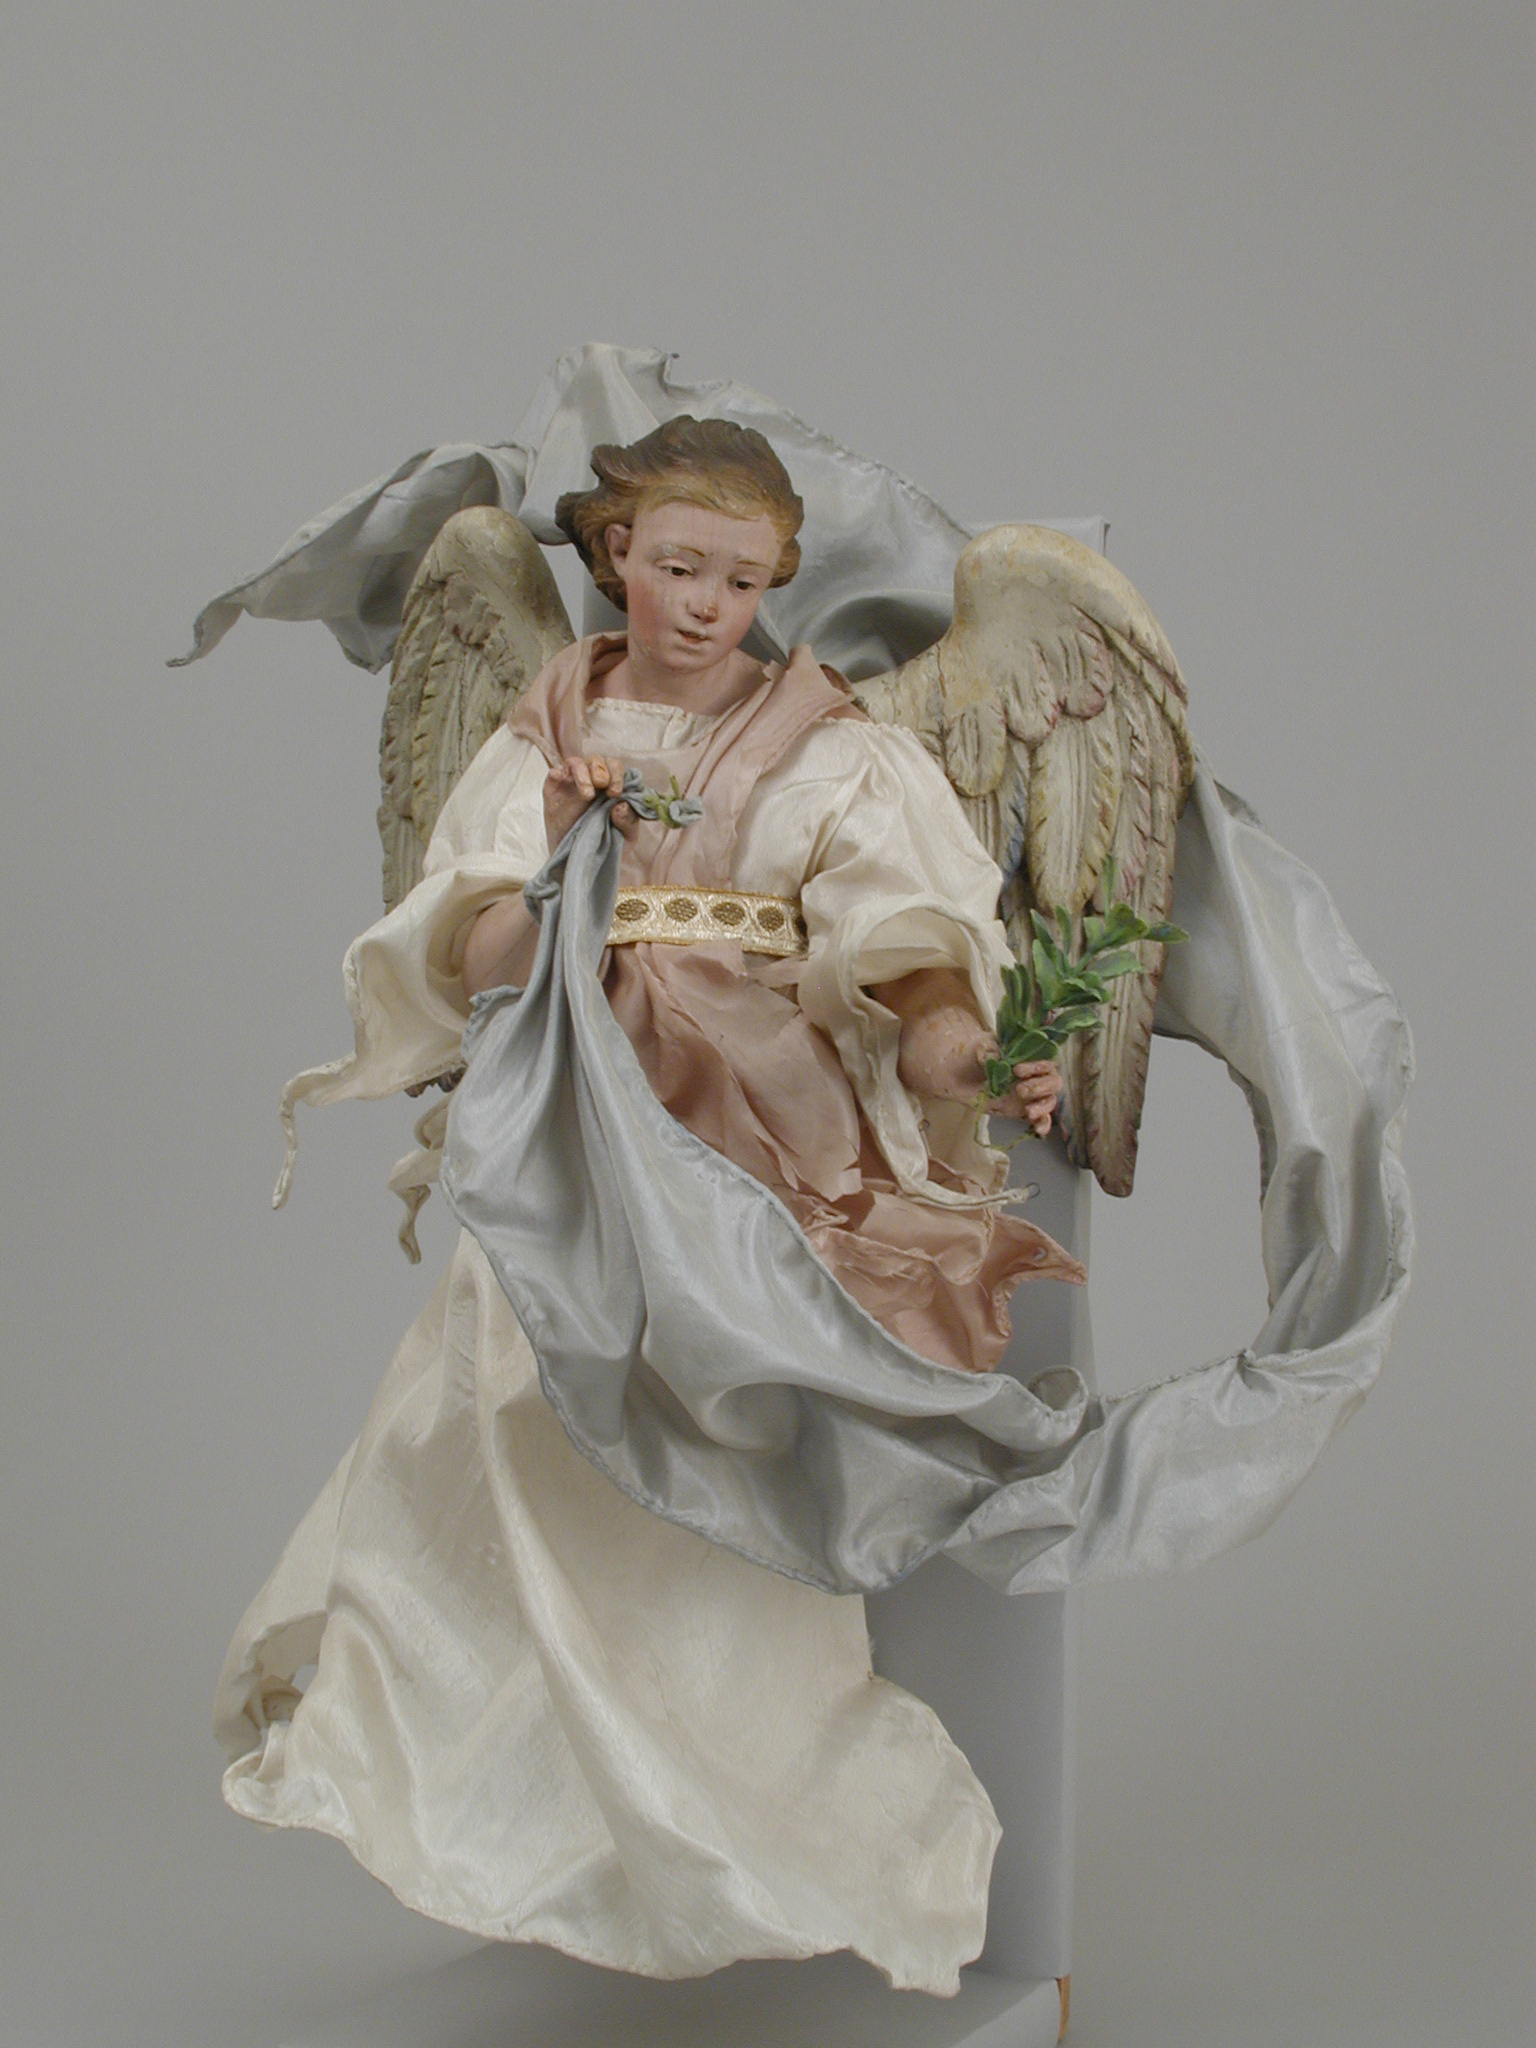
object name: crèche figure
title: Angel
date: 1767-1833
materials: silk, wood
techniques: polychrome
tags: angels